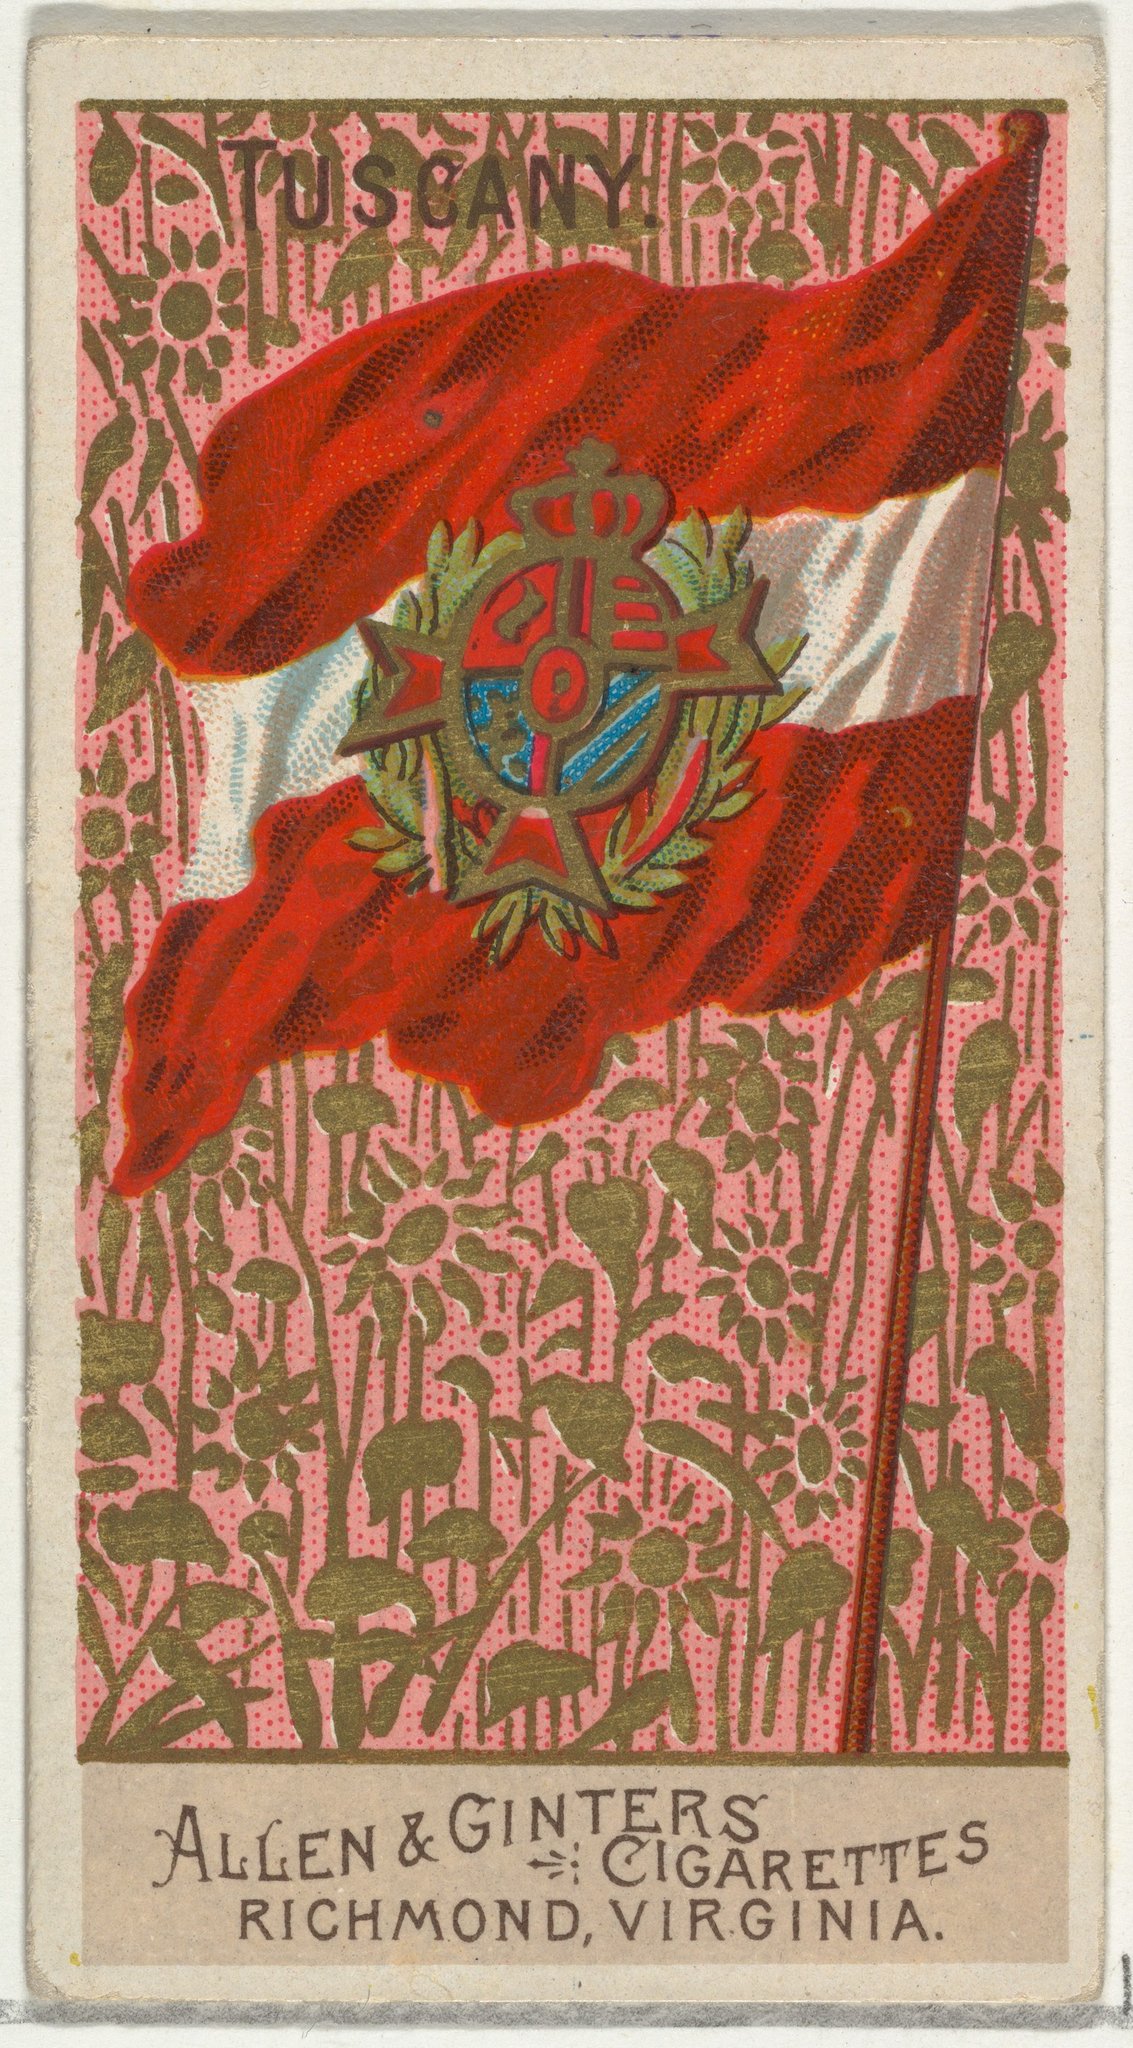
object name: print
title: Tuscany, from Flags of All Nations, Series 2 (N10) for Allen & Ginter Cigarettes Brands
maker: allen & ginter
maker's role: publisher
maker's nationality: american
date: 1890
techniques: color lithograph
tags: flags